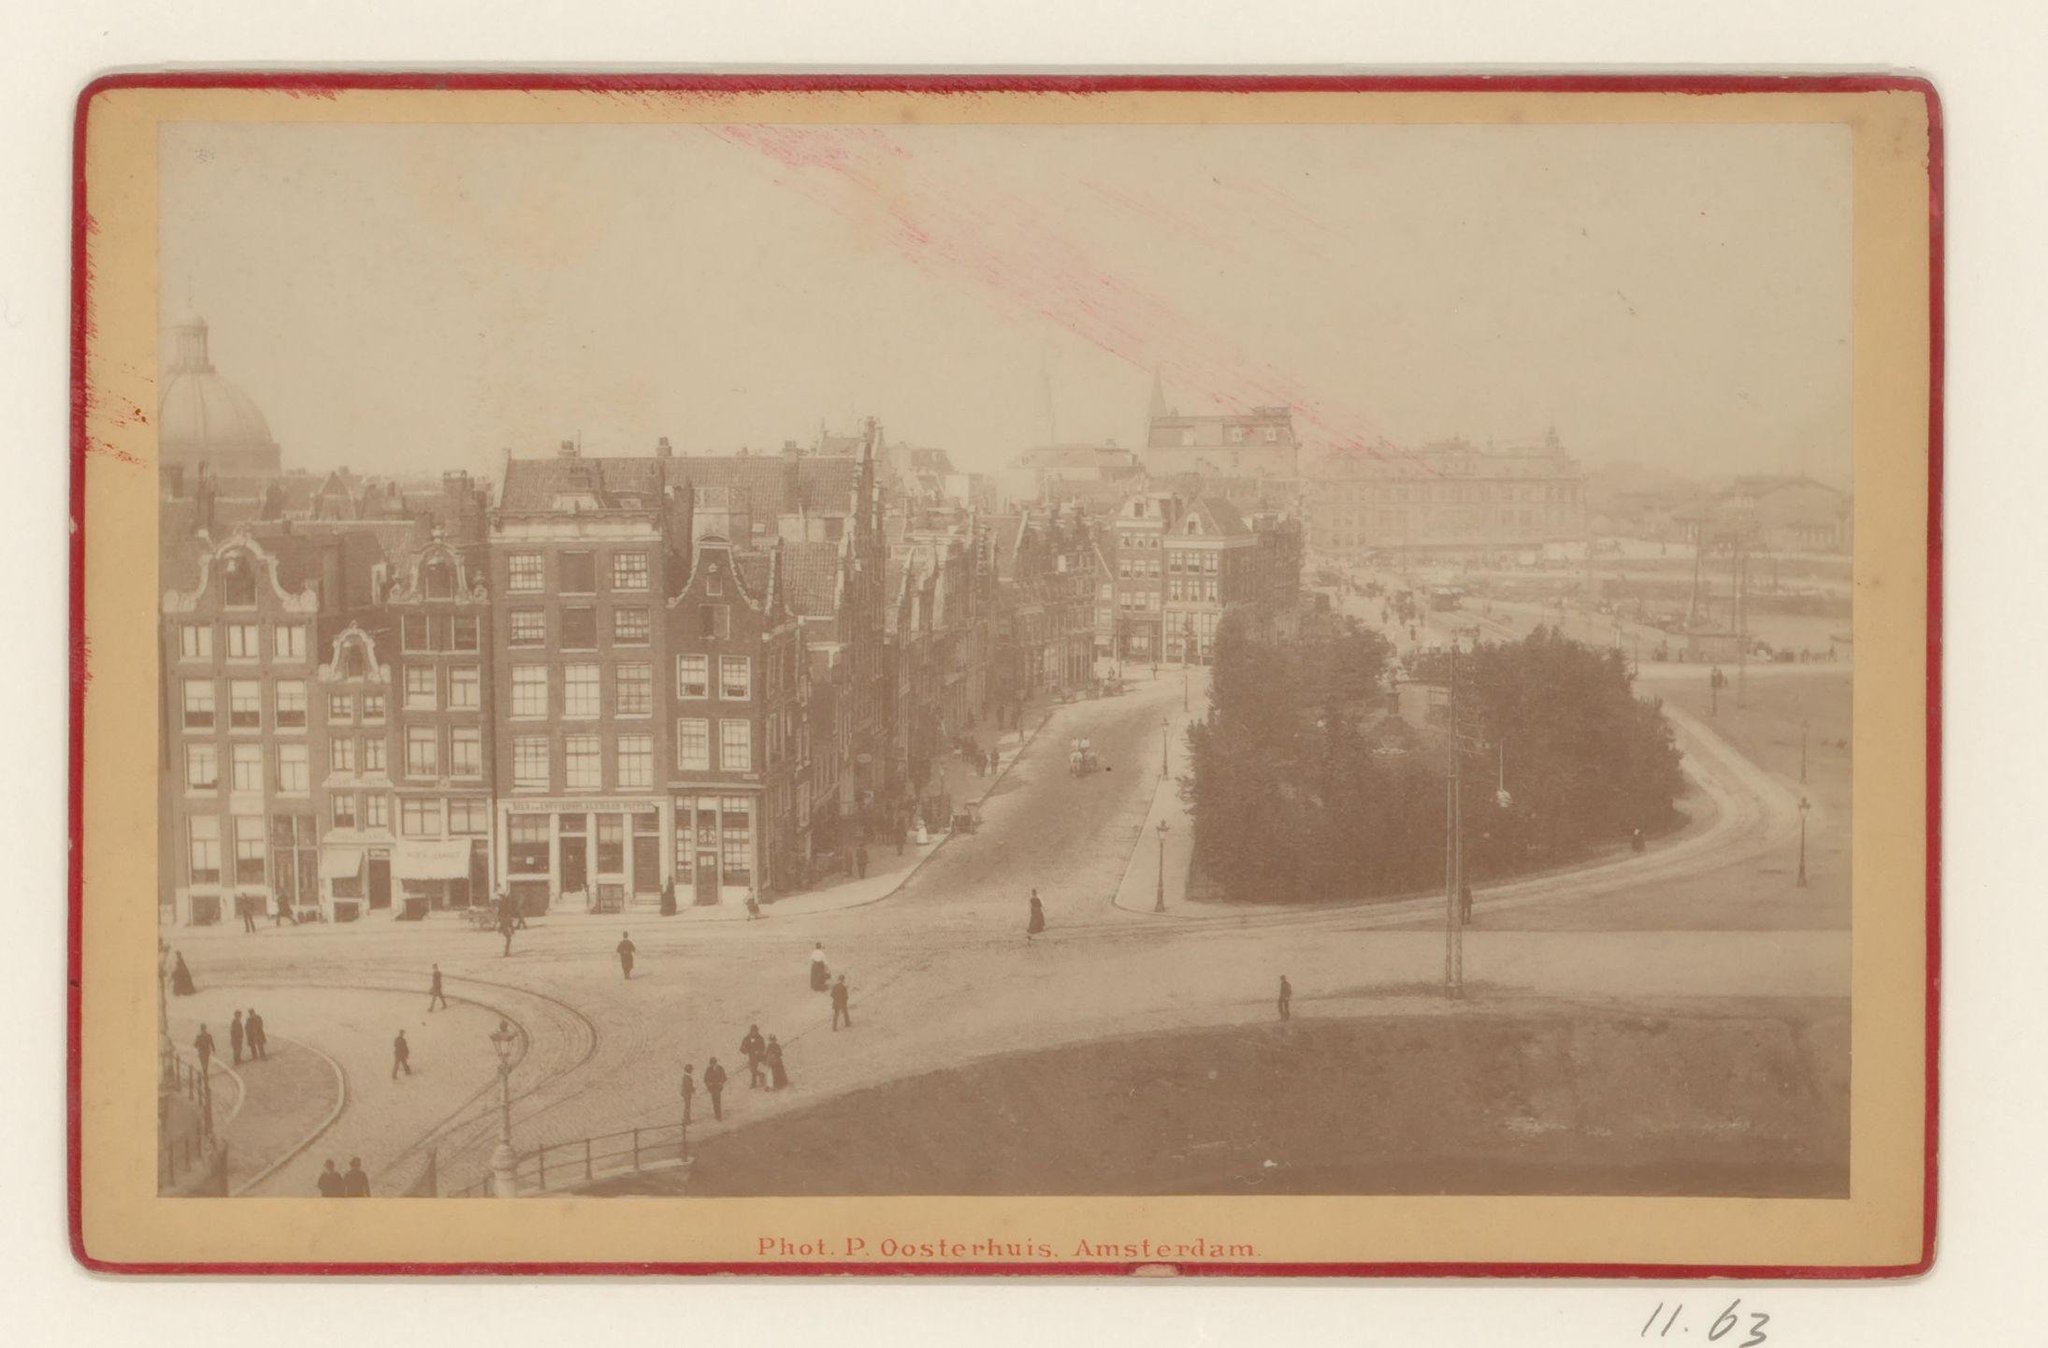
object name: cabinet photograph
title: Gezicht op het Damrak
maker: pieter oosterhuis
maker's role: draughtsman, print maker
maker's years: 1816-1885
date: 1831-1890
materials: cardboard, paper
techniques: albumen print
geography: amsterdam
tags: city-view in general; 'veduta', the usual house or row of houses, street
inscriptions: inscription: ‘Damrak voor de bouwing van het / Victoria-hotel / 59.’, collector's mark: ‘11.63’ Lugt 1641b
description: Onderwerpsrubriek binnen de Atlas Amsterdam: Prinsengracht, Korte Prinsengracht, Prins Hendrikkade. Zie ook Portefeuille 1: gezichten van het IJ op de stad.